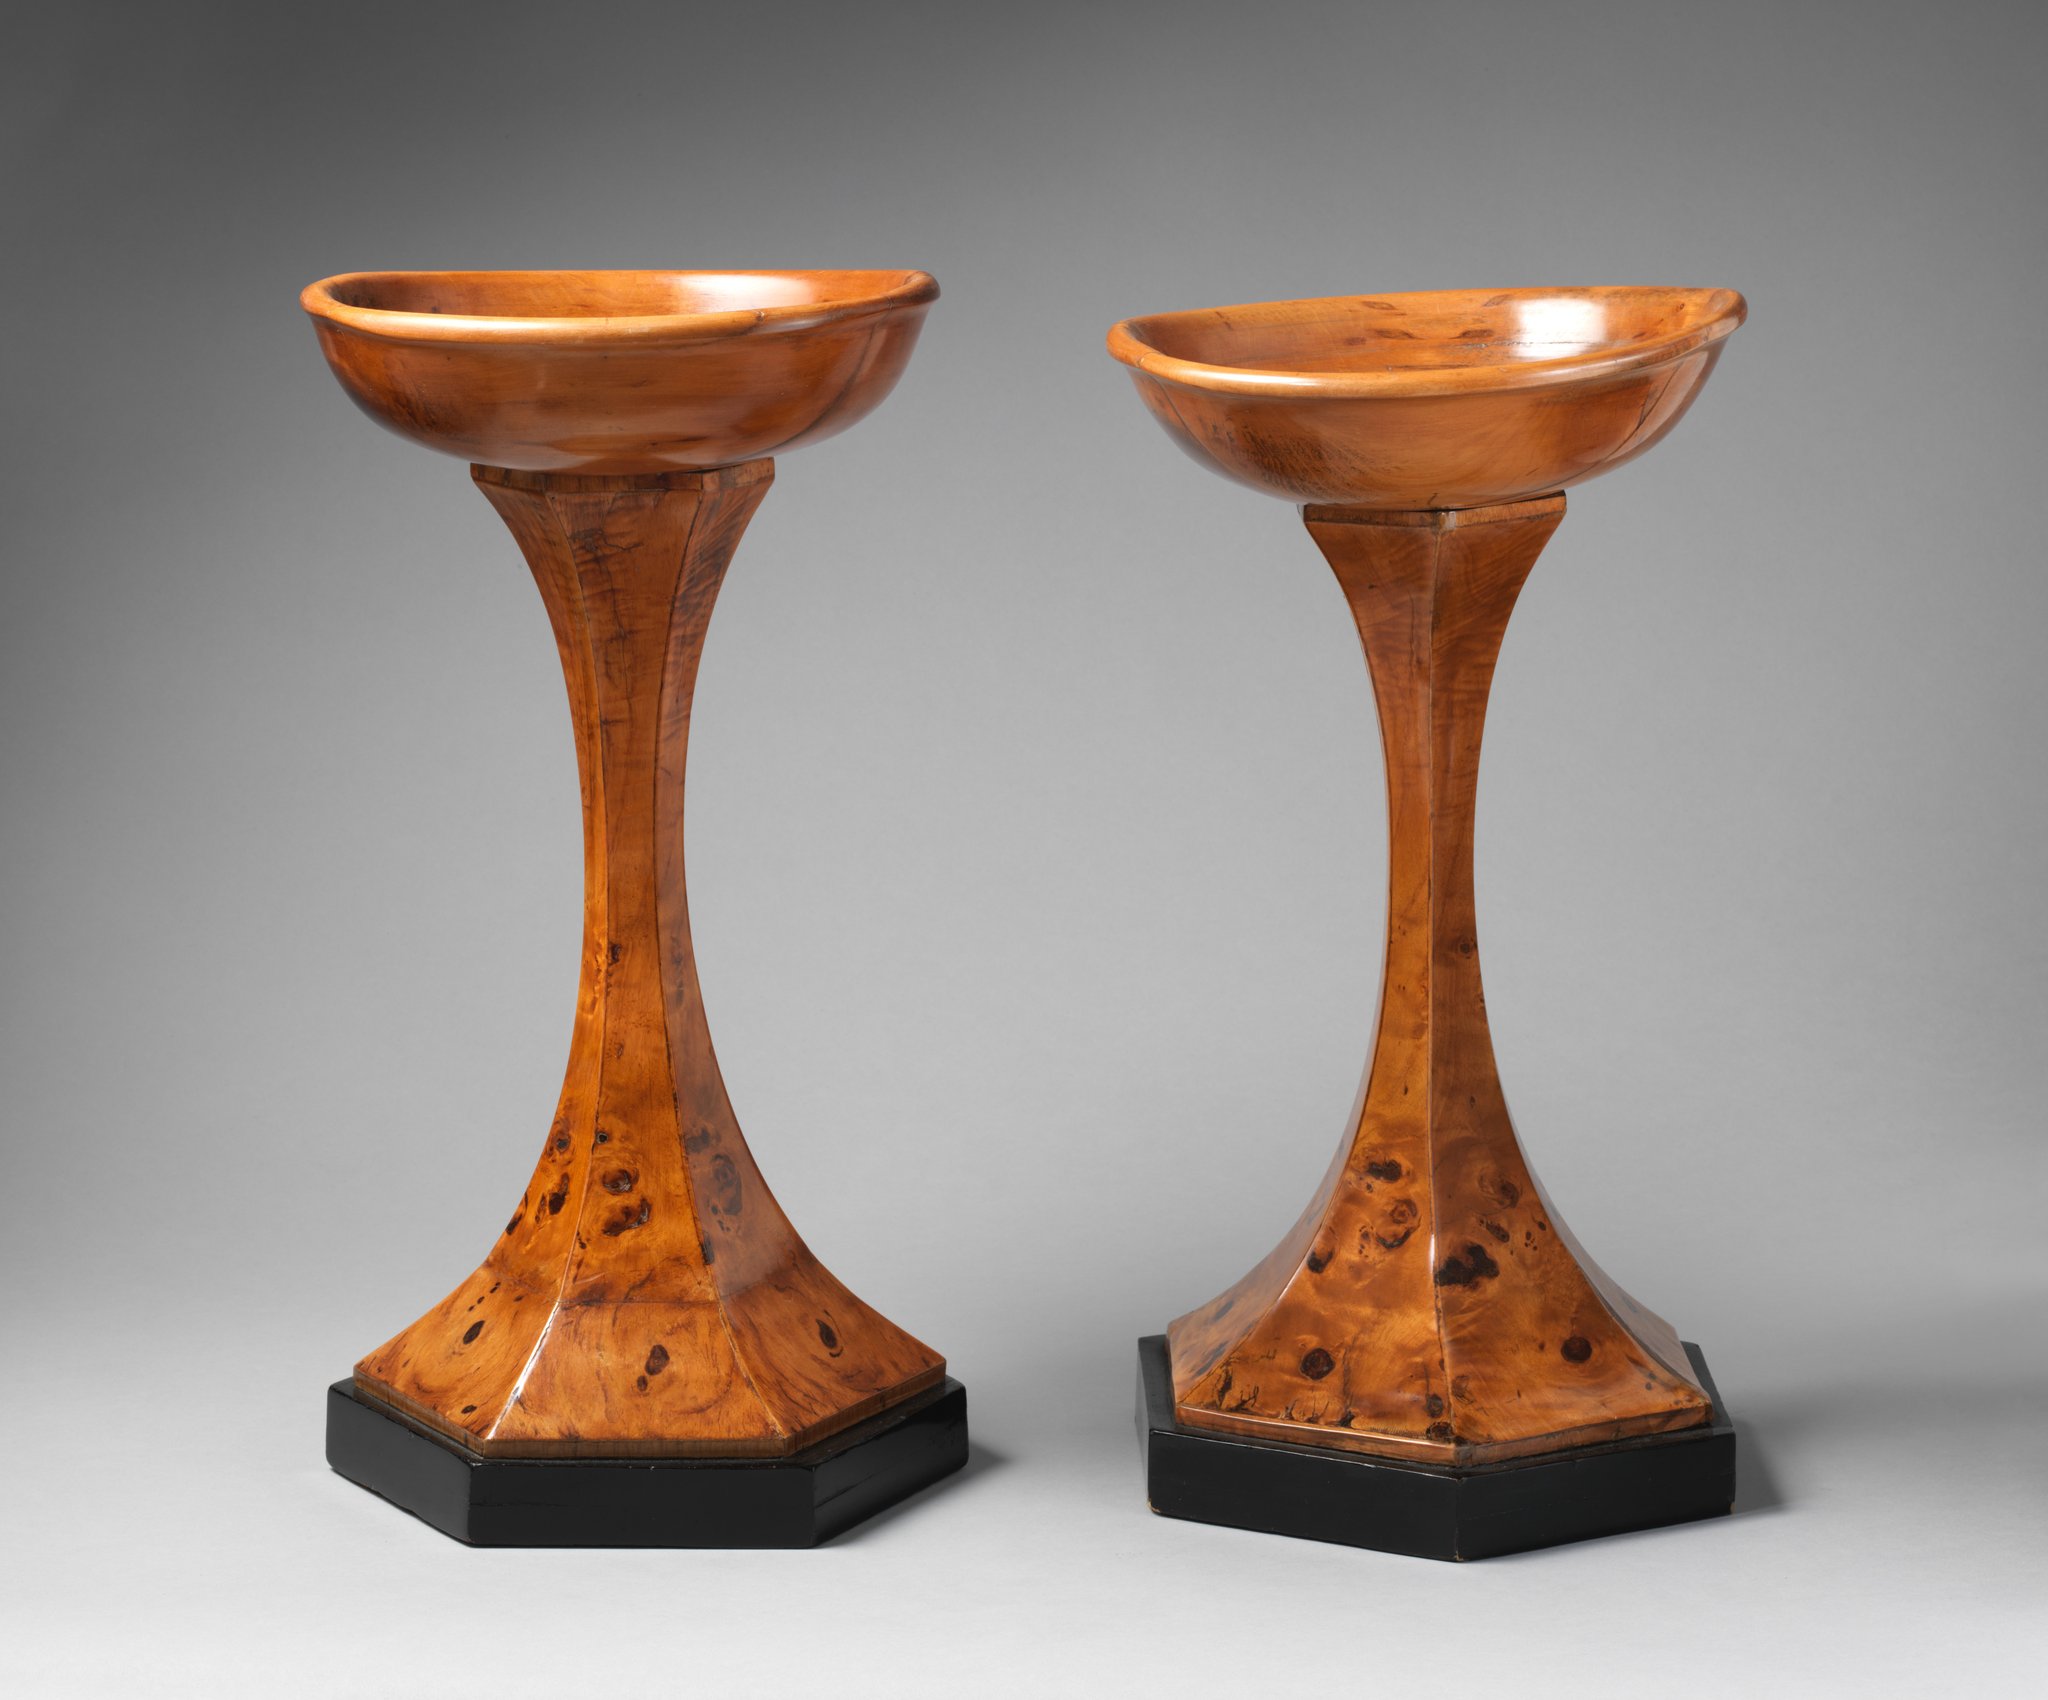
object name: spitoons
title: Pair of spitoons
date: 1830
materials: wood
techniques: veneering